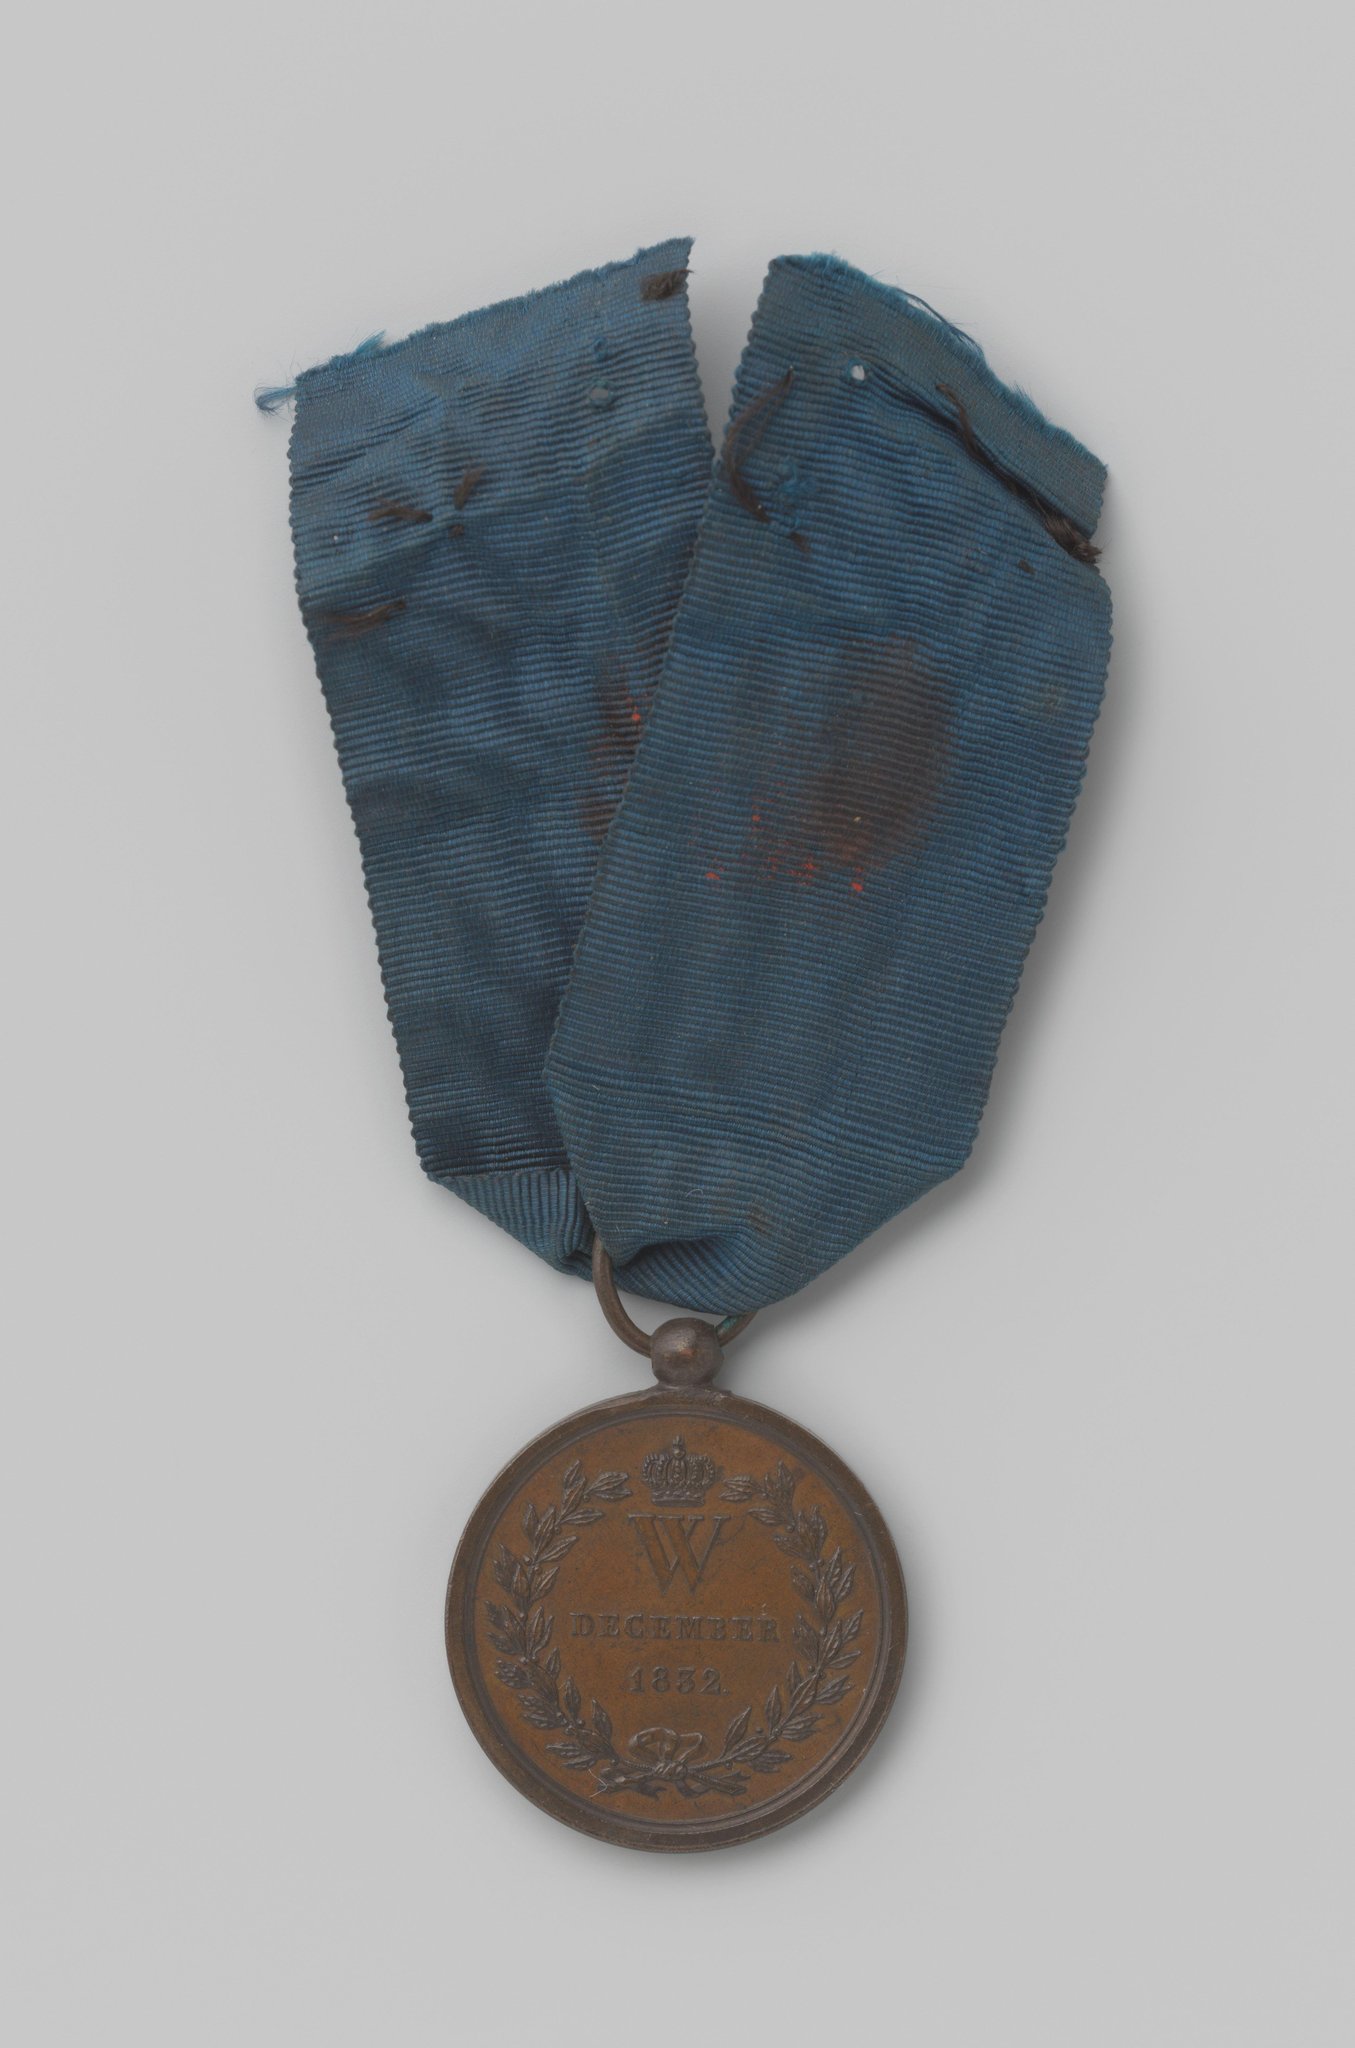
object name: medal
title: Citadel-medaille met lakzegel op lint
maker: Anonymous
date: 1832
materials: bronze, lacquer, textile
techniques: forging, lacquer, striking, weave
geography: netherlands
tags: strijd om de citadel van antwerpen (1832)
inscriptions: name: ‘CITADEL VAN ANTWERPEN’, : ‘Gekroonde W’, : ‘DECEMBER 1832’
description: Citadel-medaille met blauw lint waarop een rood lakzegel. Het blauwe lint is van textiel waarop zich een rood lakzegel bevindt. De medaille is rond en bronskleurig met een verhoogde rand. In het midden staat de citadel van Antwerpen gegraveerd. Op de andere zijde staat een gekroonde W met daaronder de tekst DECEMBER 1832 omgeven door een laurwerkrans. De medaille zit bevestigd aan een draagoog.